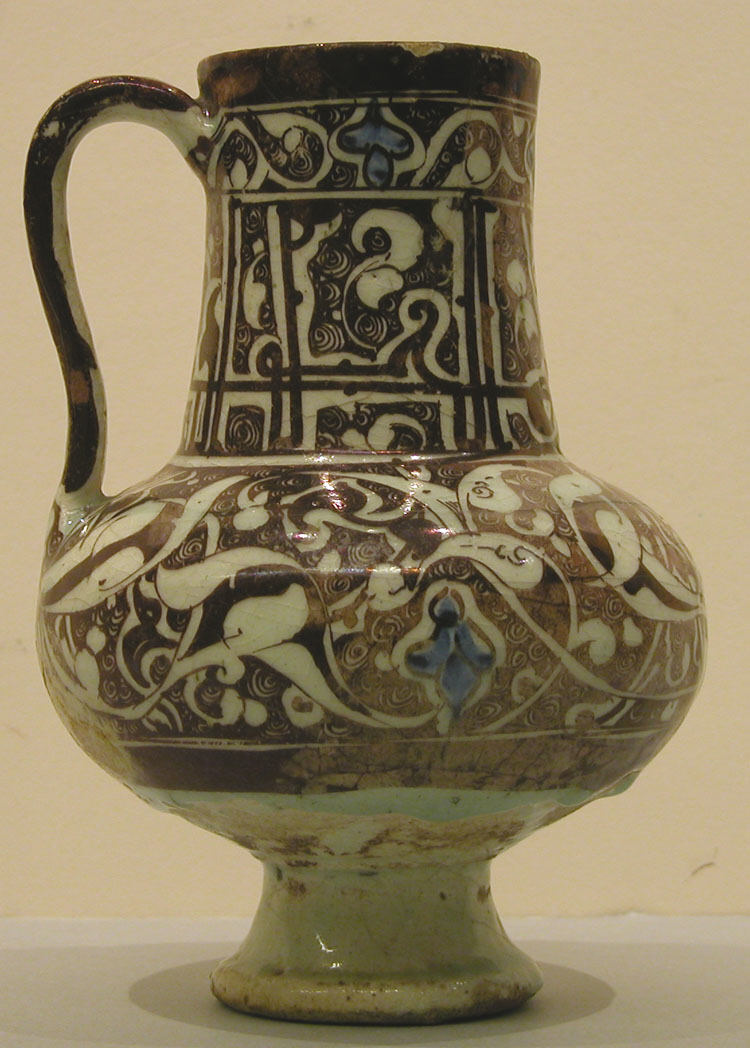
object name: ewer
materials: glaze, stonepaste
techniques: luster painting, painting, underglaze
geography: syria